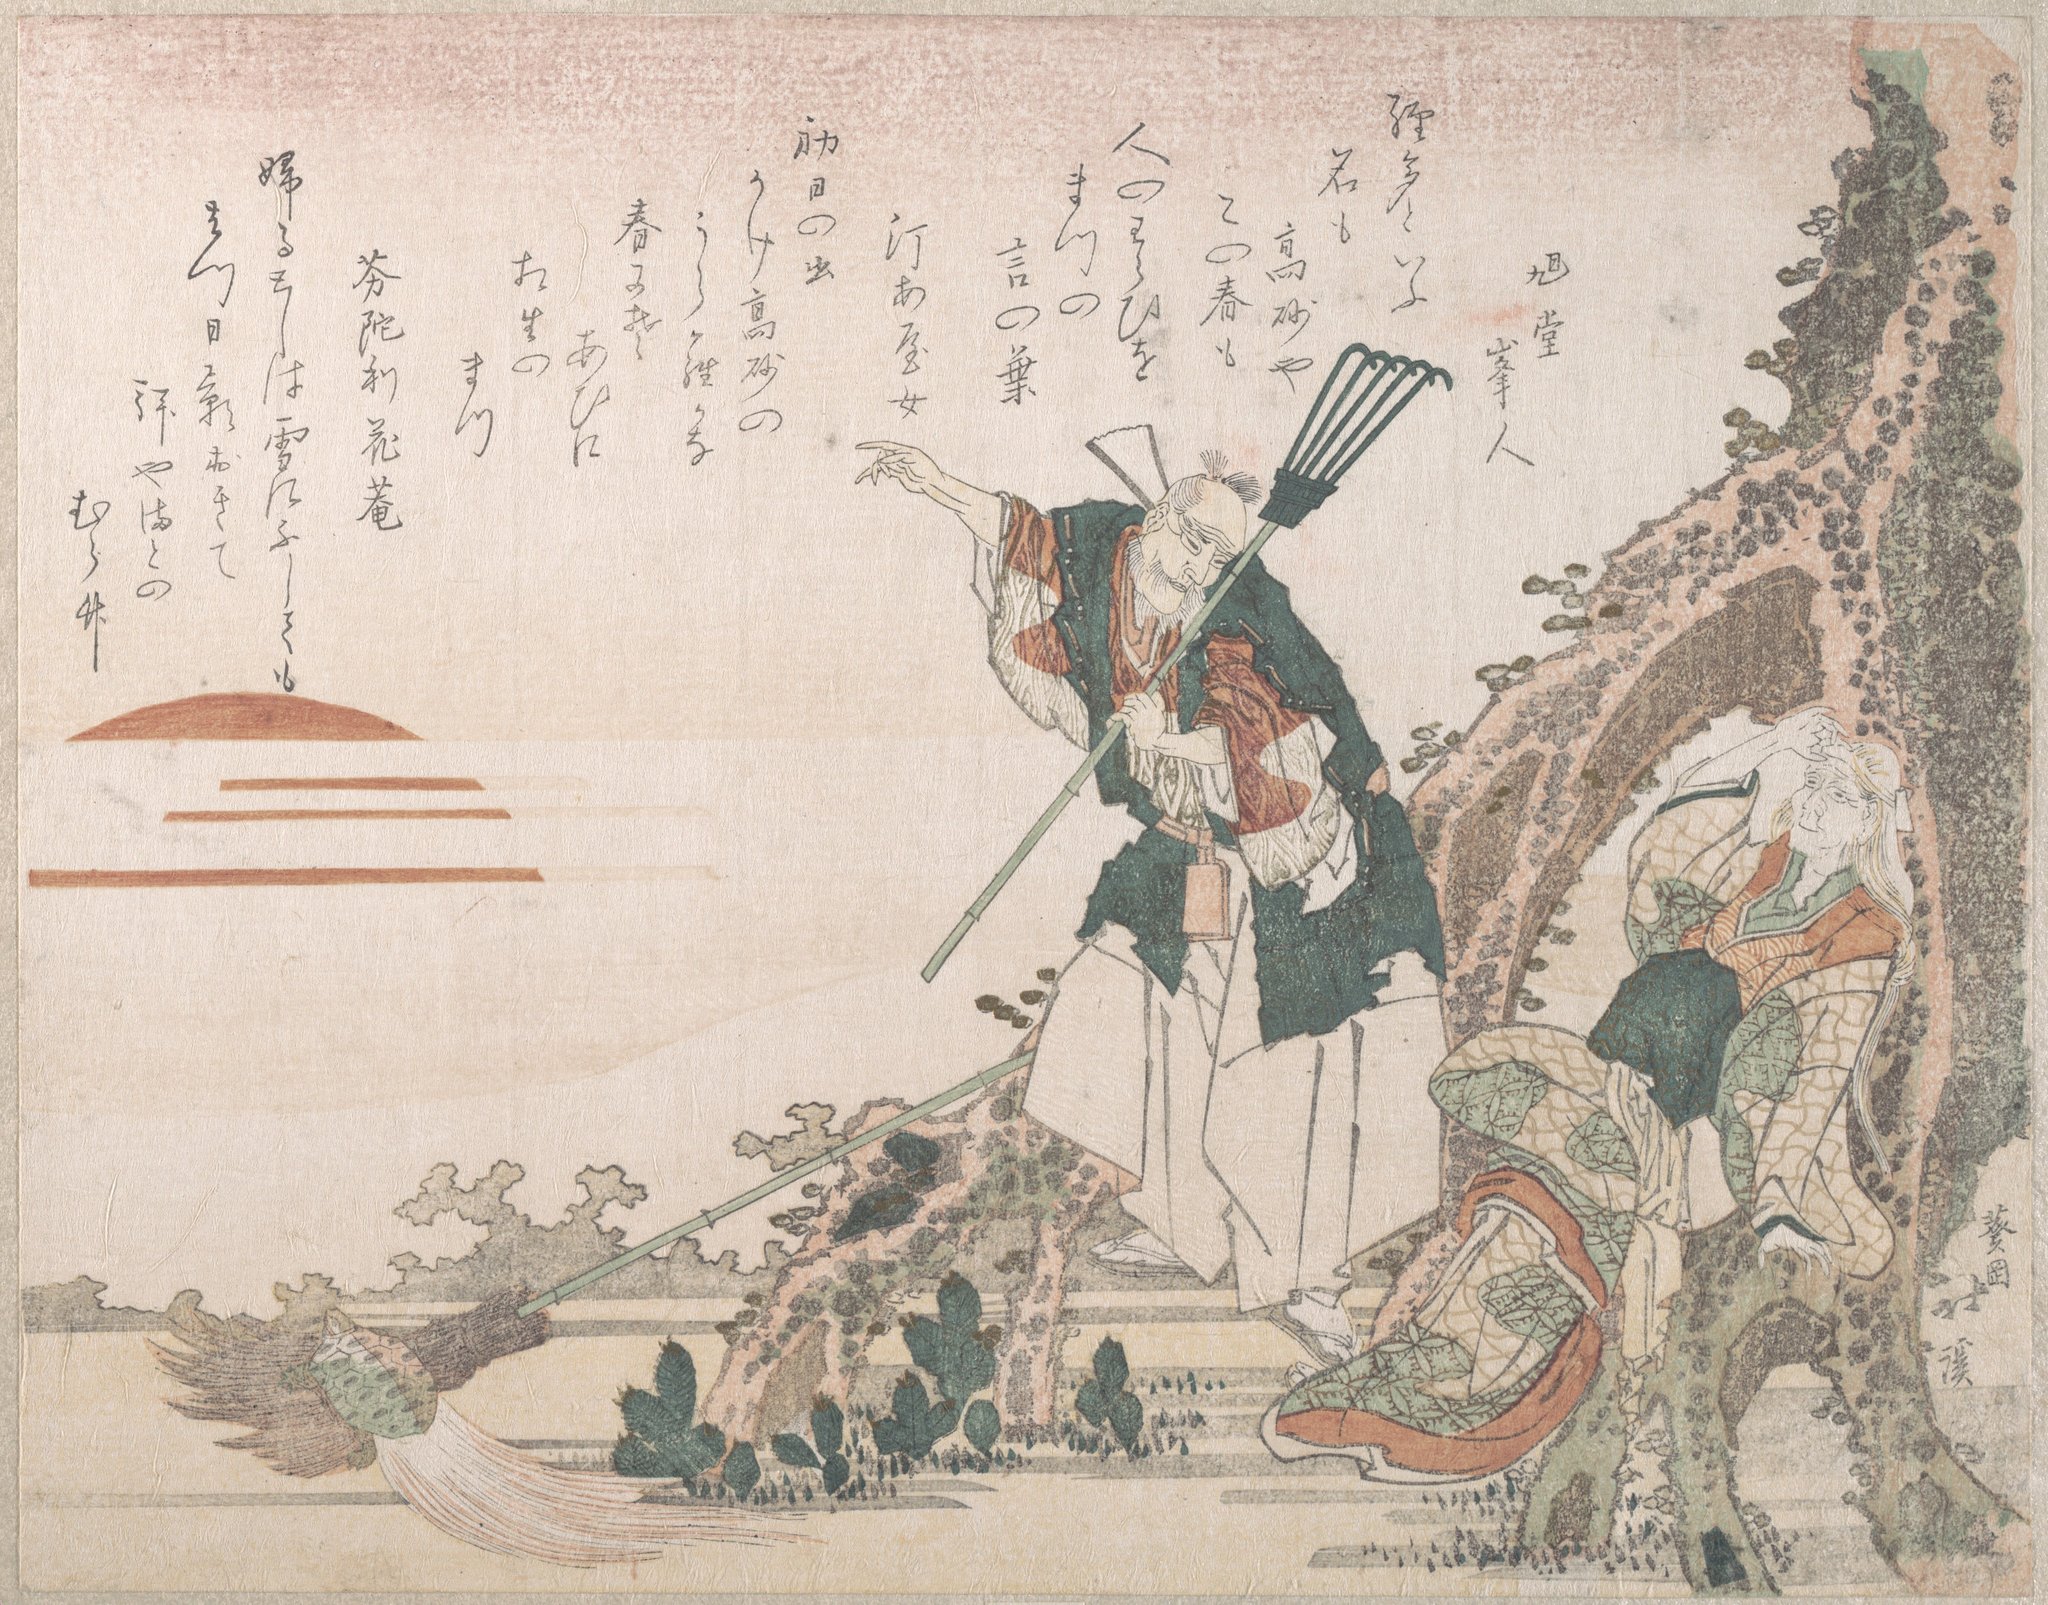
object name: print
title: Jo and Uba of Takasago Looking at the Rising Sun; Symbolic Representation of Longevity and Conjugal Harmony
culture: japanese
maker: totoya hokkei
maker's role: artist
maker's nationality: japanese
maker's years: 1780-1850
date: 1801-1900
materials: ink, paper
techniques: surimono, woodblock print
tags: men,women,turtles,landscapes